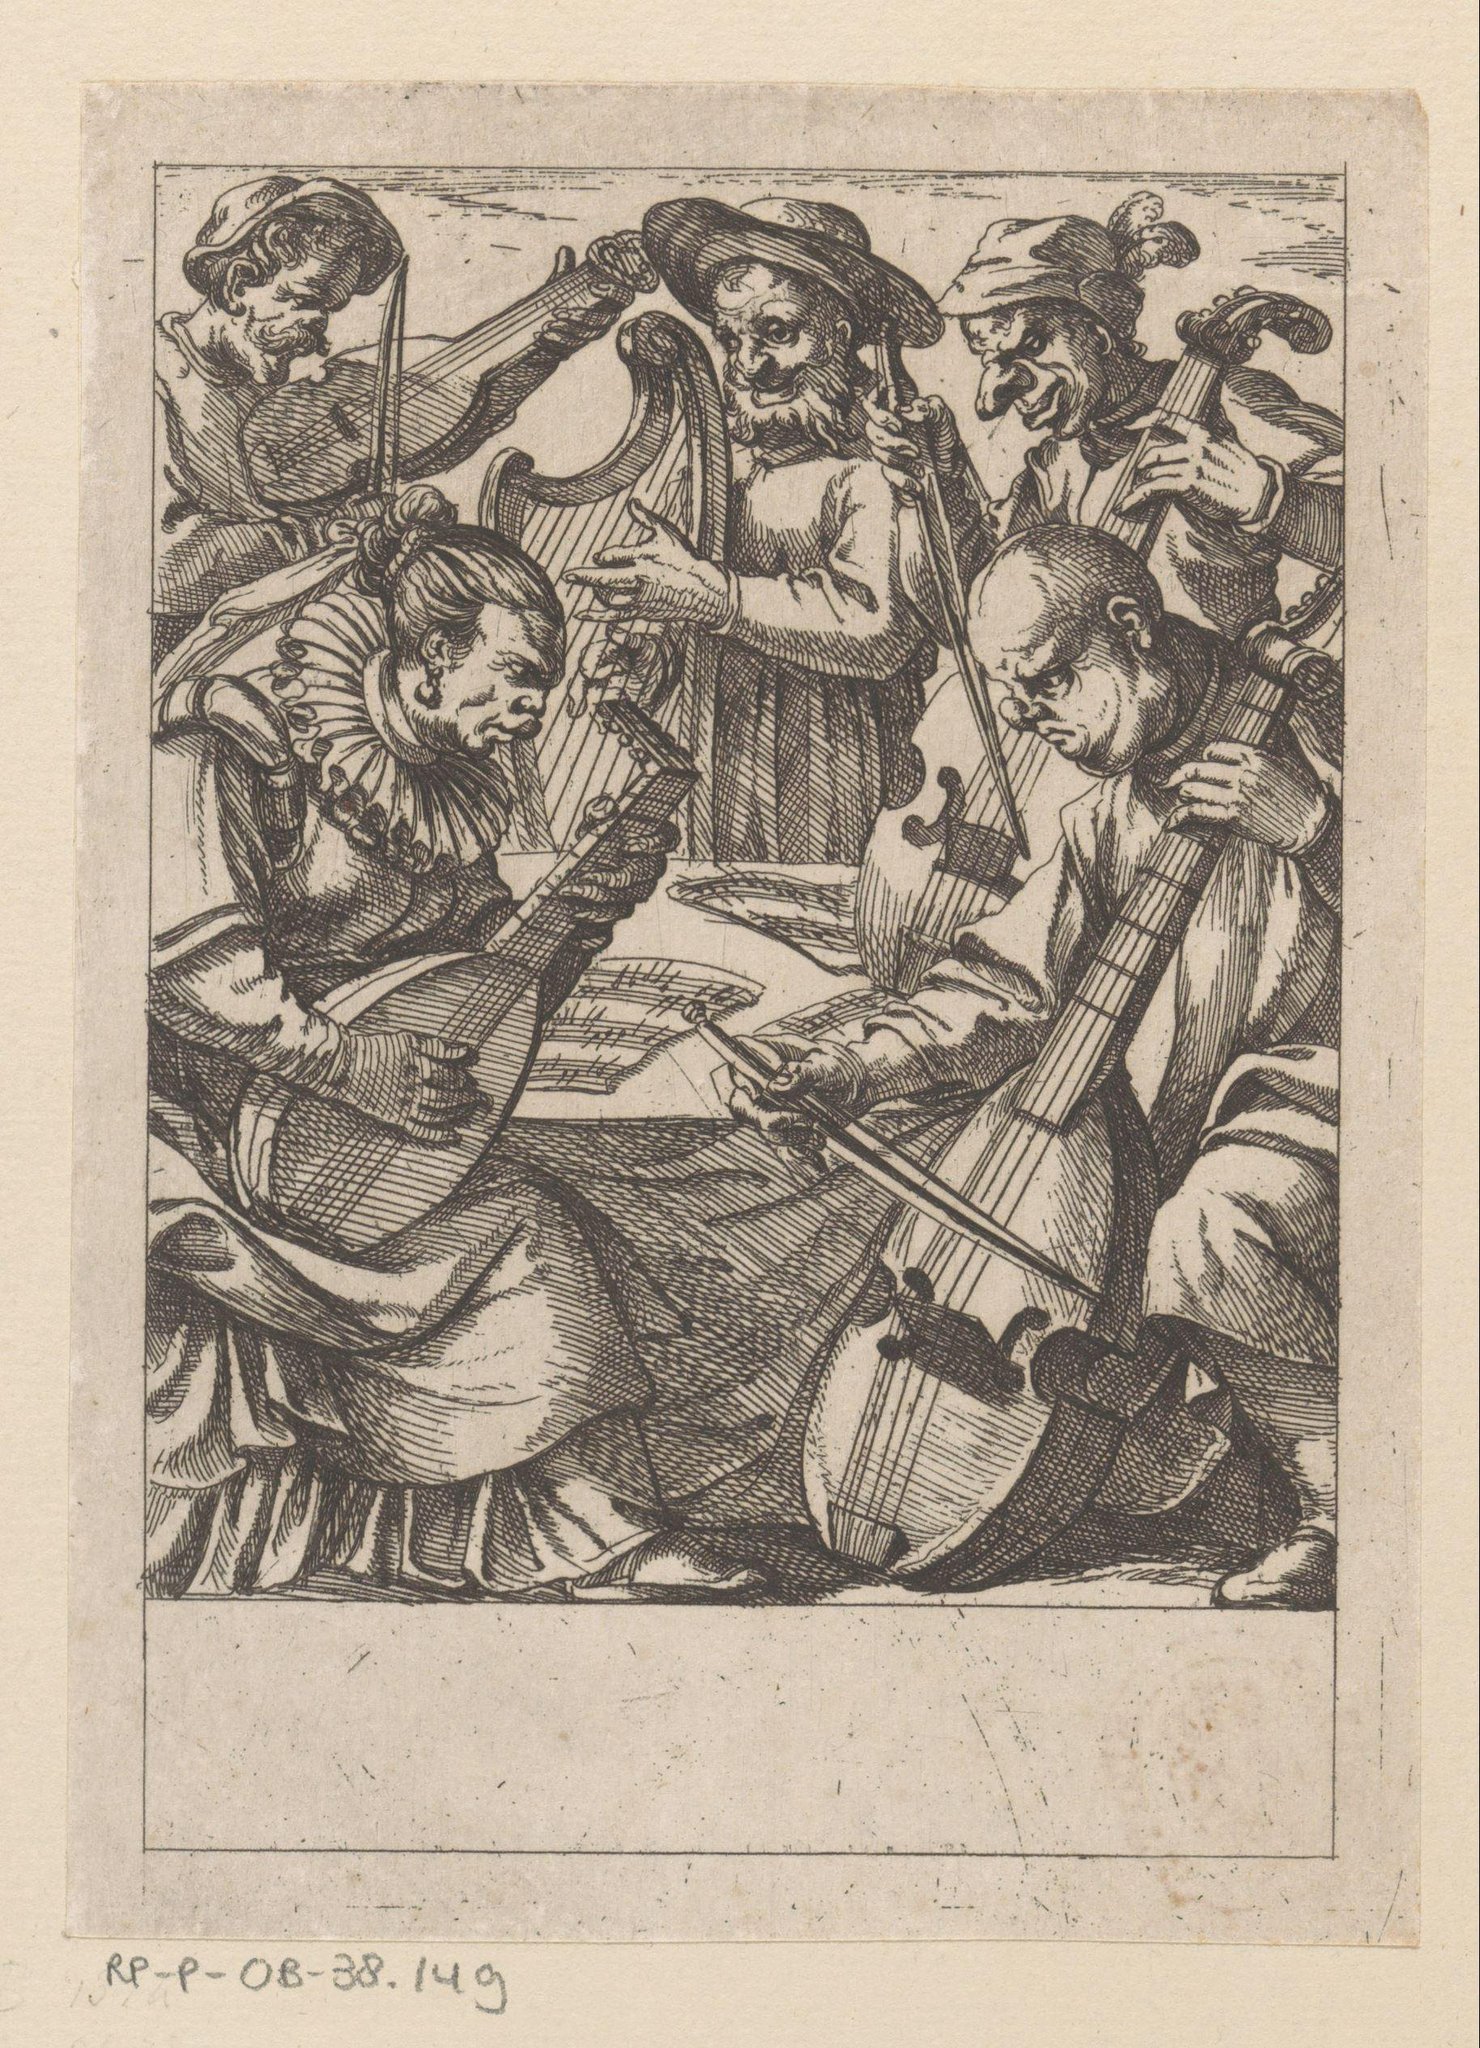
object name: print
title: Groteske figuren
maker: antonio tempesta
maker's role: draughtsman, painter, print maker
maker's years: 1555-1630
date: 1565-1630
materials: paper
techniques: etching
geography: italy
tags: small group of musicians, chamber orchestra, jazz band, caricatures (human types)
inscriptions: collector's mark: Lugt 240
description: Musicerend gezelschap rond een tafel. Vier mannen en één vrouw met groteske koppen bespelen luit, harp en strijkinstrumenten.